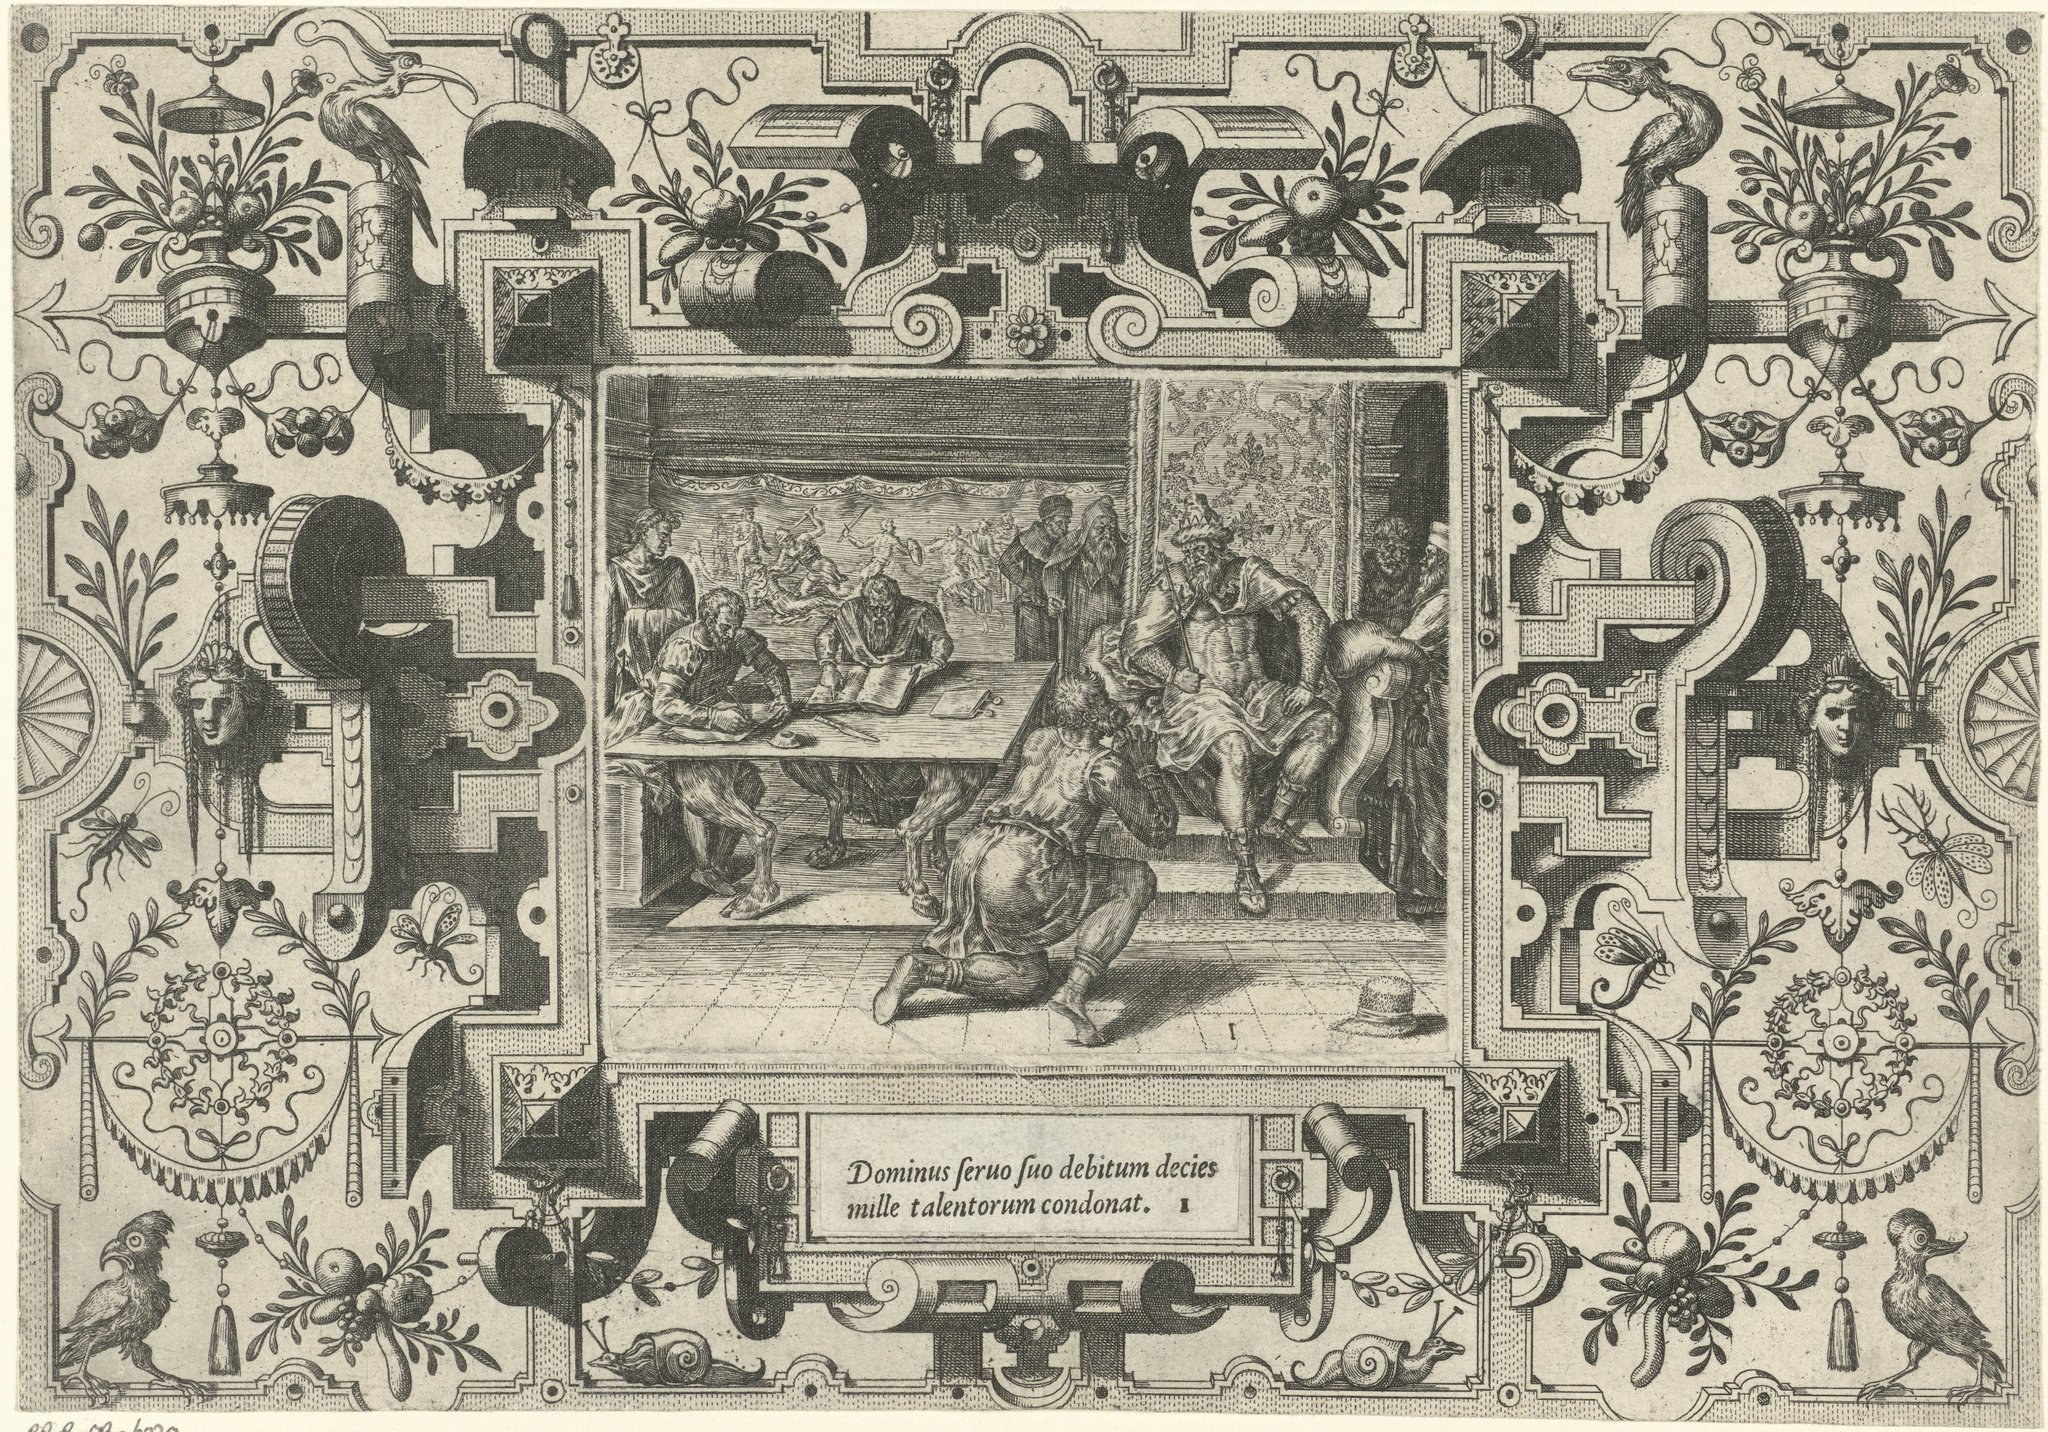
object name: print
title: Koning scheldt de onbarmhartige slaaf zijn schulden kwijt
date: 1568-1577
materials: paper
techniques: engraving, etching, letterpress printing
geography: antwerp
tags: scrollwork, strapwork ~ ornament, the unmerciful servant: the king forgives him his debts ~ parable of christ (matthew 18:23-35)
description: Een dienaar knielt voor zijn koning en smeekt hem om geduld met hem te hebben, zodat hij nog wat tijd heeft om zijn schuld te betalen. De koning krijgt medelijden en scheldt hem zijn schuld kwijt. Aan de tafel naast de koning een schrijvende man en iemand die uit een boek de schulden voorleest. De voorstelling is gevat in een lijst met rolwerk en ornamenten.